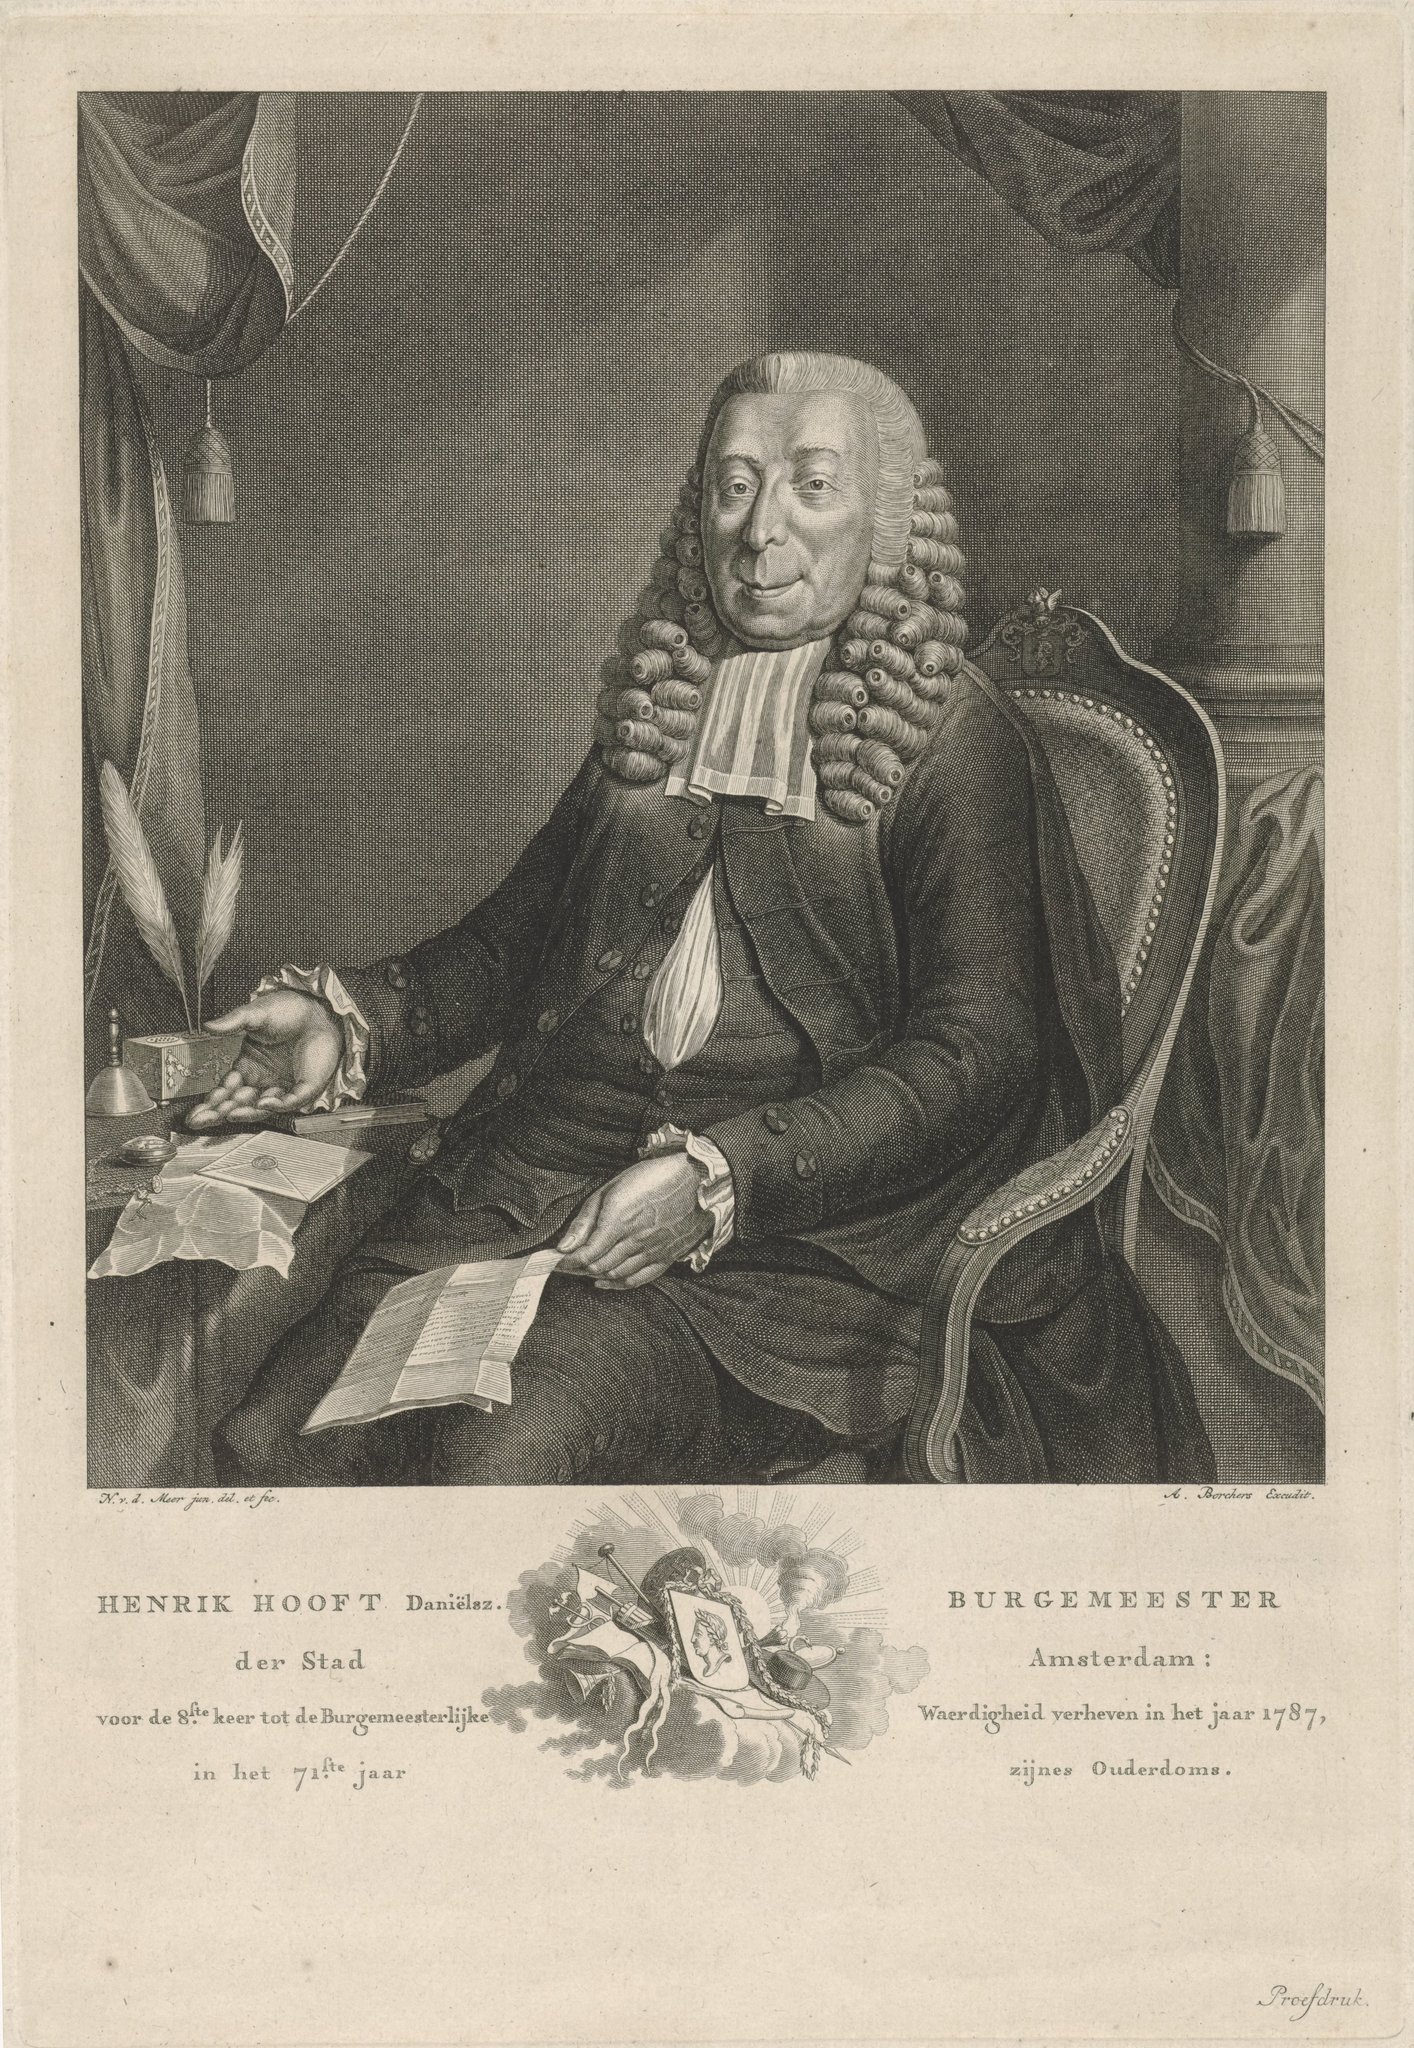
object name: print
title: Portret van Hendrik Danielsz. Hooft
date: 1787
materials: paper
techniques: engraving, etching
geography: amsterdam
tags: amsterdam, mayor, hendrik danielsz. hooft, writing tools, letter, envelope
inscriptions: collector's mark: Lugt 2228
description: Portret van Hendrik Danielsz. Hooft, burgemeester van Amsterdam, gezeten aan een tafel met een brief in zijn hand. Op tafel een envelop, schrijfveren, een bel en een horloge. Midden onder in de marge symbolen van Hoofts leidersrol. Onder andere een fasces, een caduceus, het portret van een Romeinse keizer, een hoed, een brandende fakkel, het wapenschild van Amsterdam en een opgaande zon.